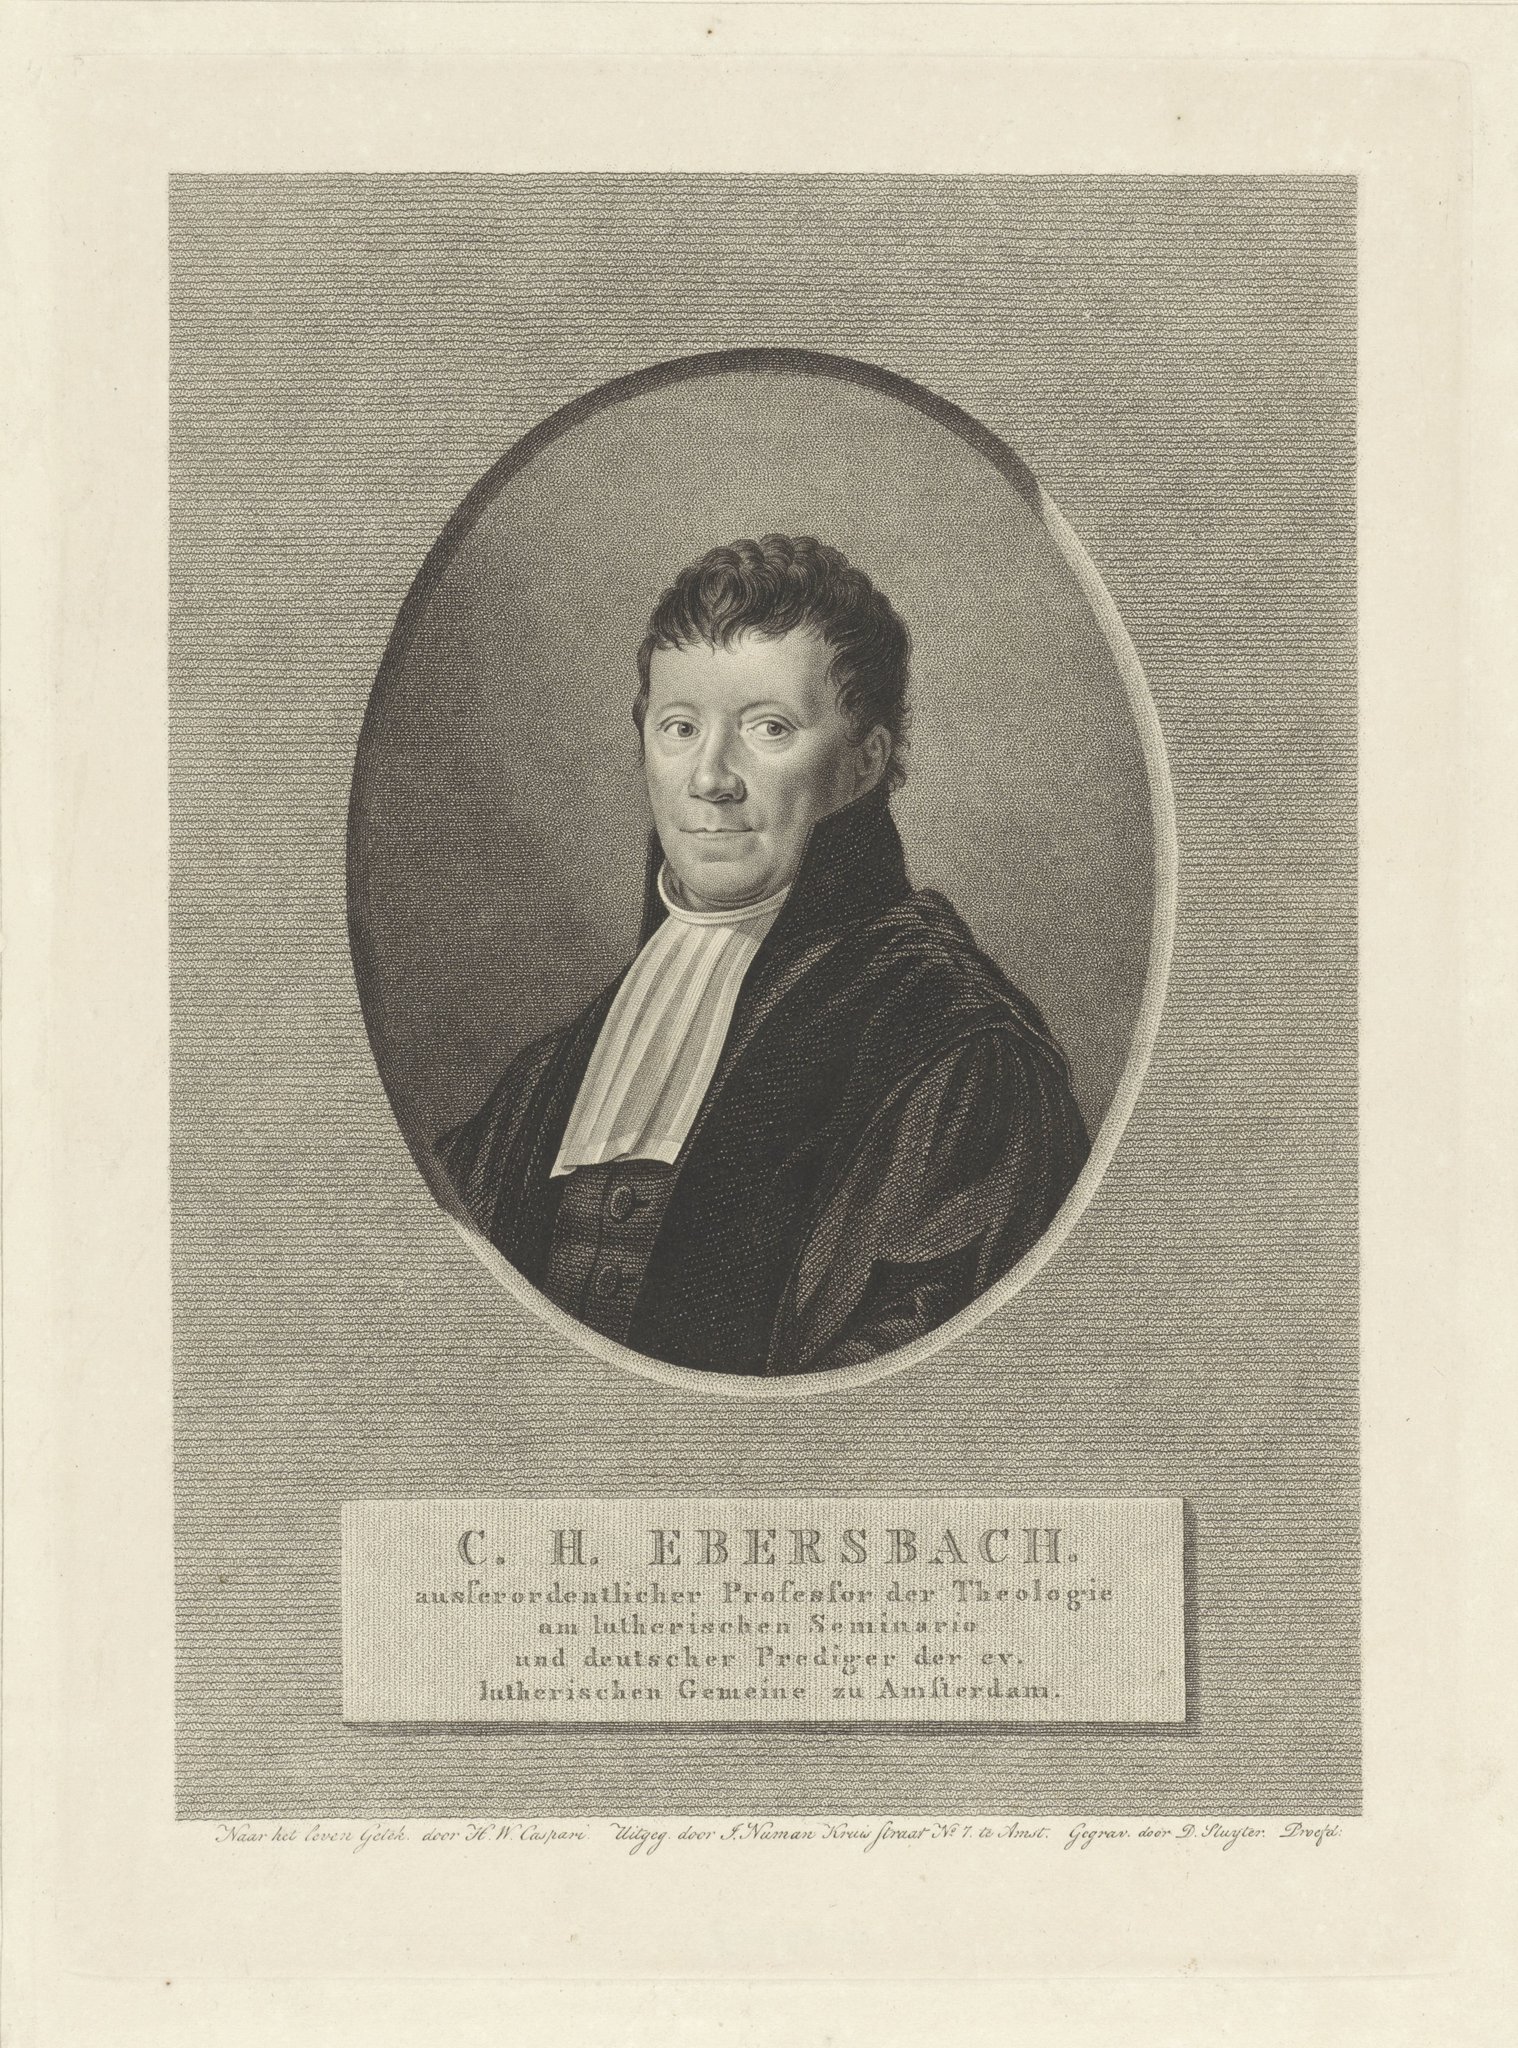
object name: print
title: Portret van Christiaan Henrich Ebersbach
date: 1818-1823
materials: paper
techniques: etching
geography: amsterdam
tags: predikant, christiaan henrich ebersbach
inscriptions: collector's mark: Lugt 2228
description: Portret van Christiaan Henrich Ebersbach, Duits predikant van de Lutherse gemeente in Amsterdam.